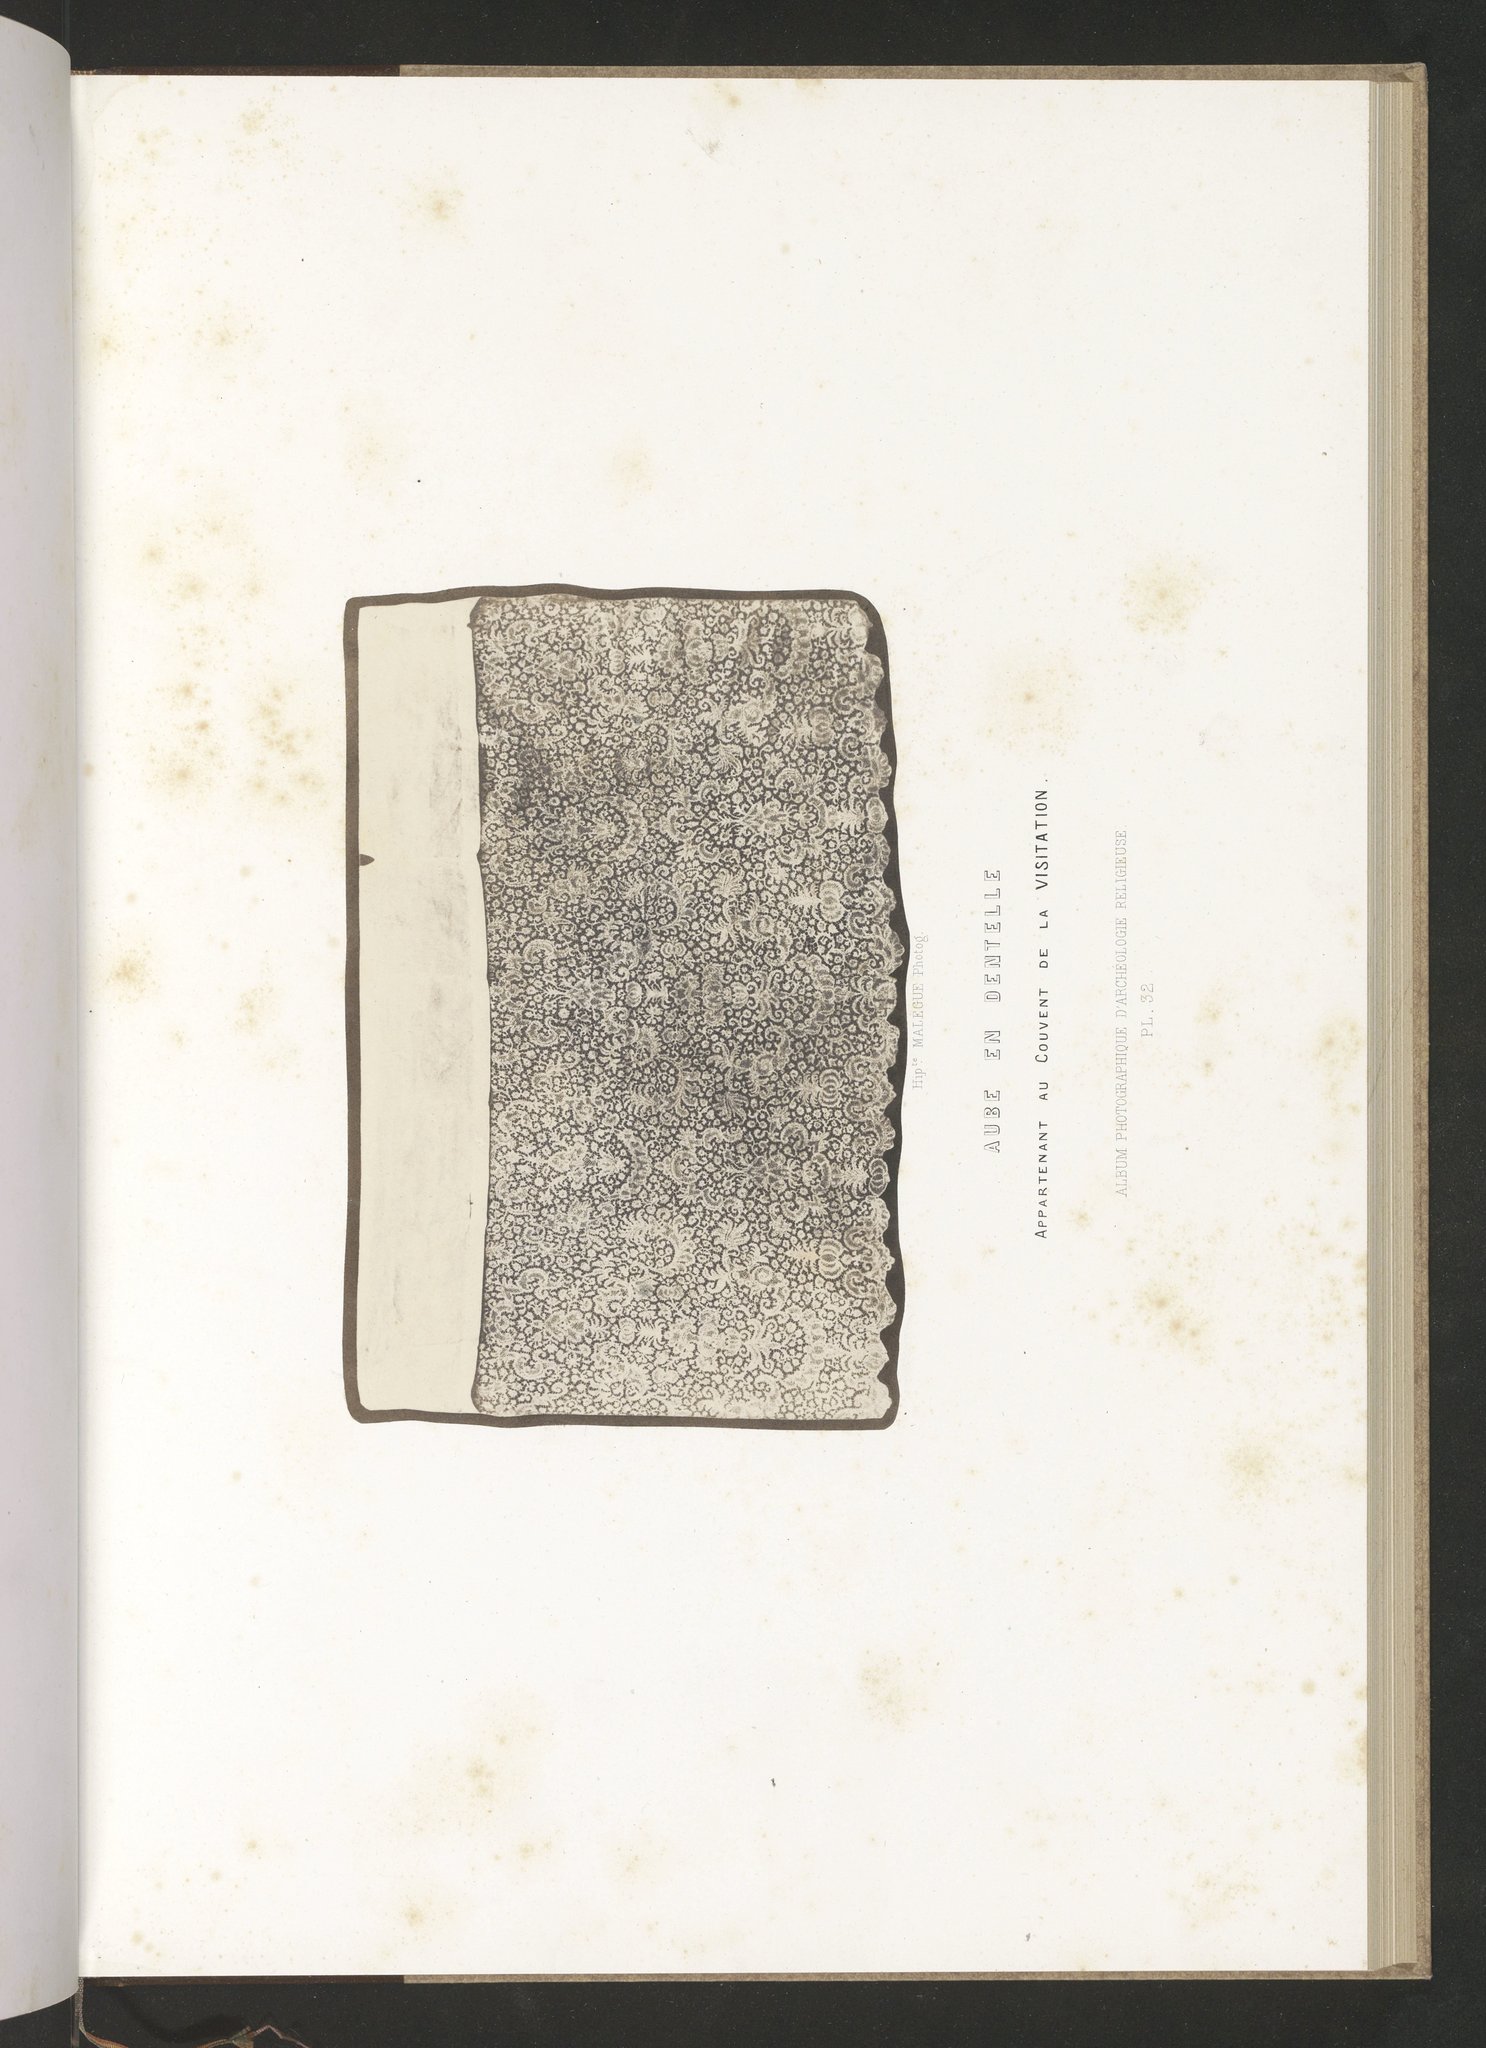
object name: page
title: Aube en dentelle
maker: hippolyte malègue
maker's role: archeoloog, fotograaf, schrijver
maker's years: 1825-1901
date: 1850-1857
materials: photographic support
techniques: salted paper print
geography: france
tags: lace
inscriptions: number: ‘PL. 32.’, inscription: ‘appartenant au couvent de la visitation.’